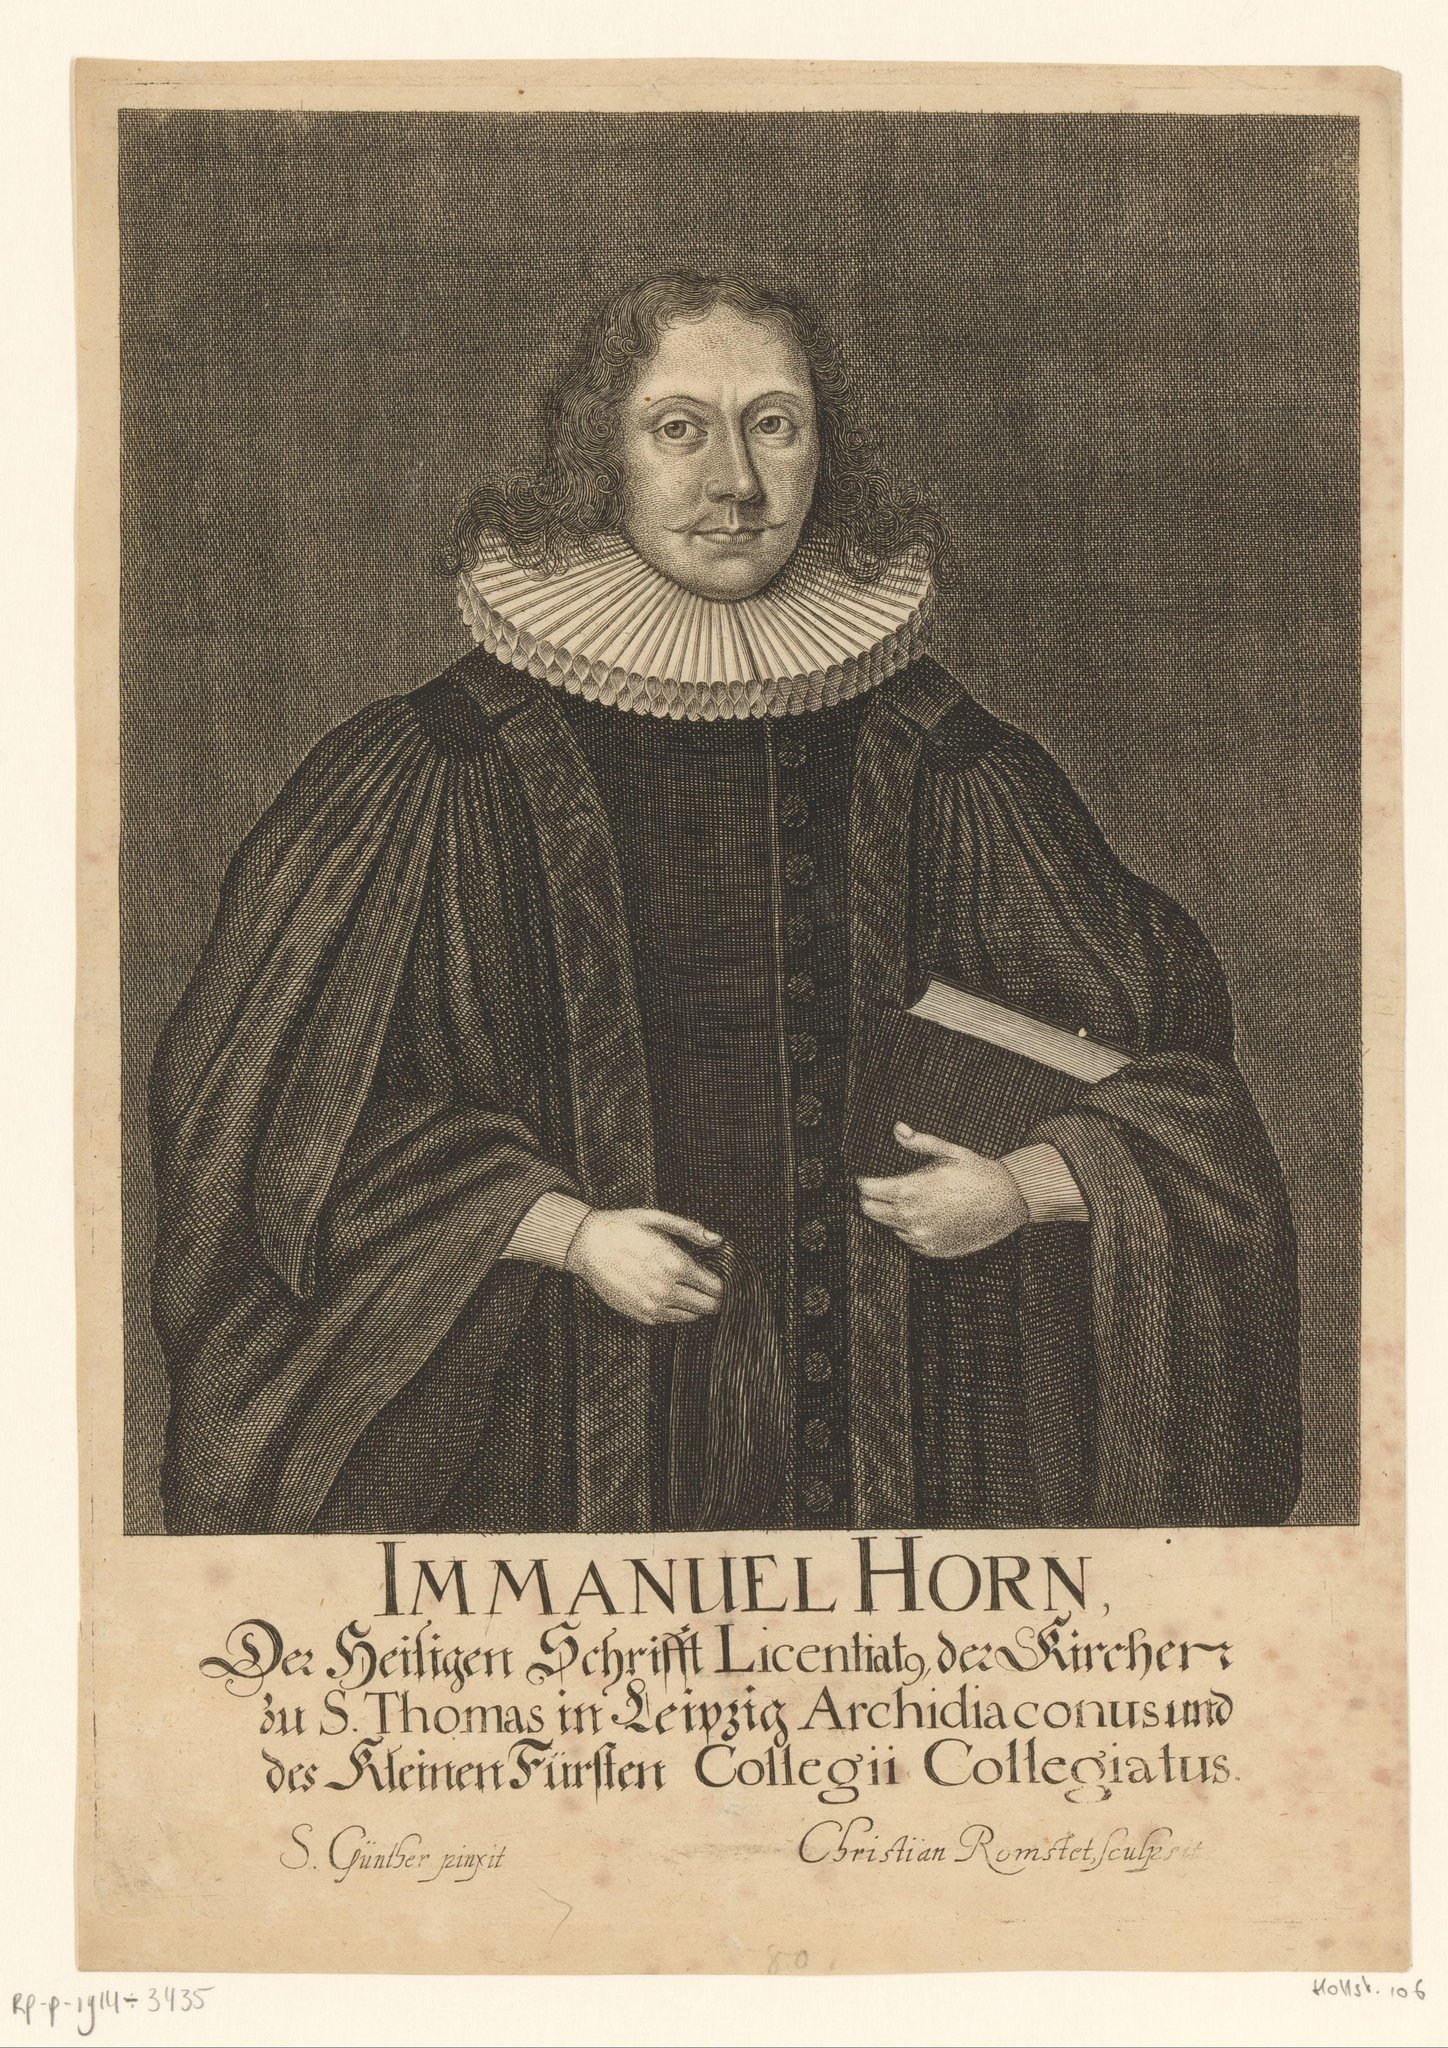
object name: print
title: Portret van Immanuel Horn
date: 1665-1721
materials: paper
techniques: engraving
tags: theologian, historical persons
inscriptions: collector's mark: Lugt 2228